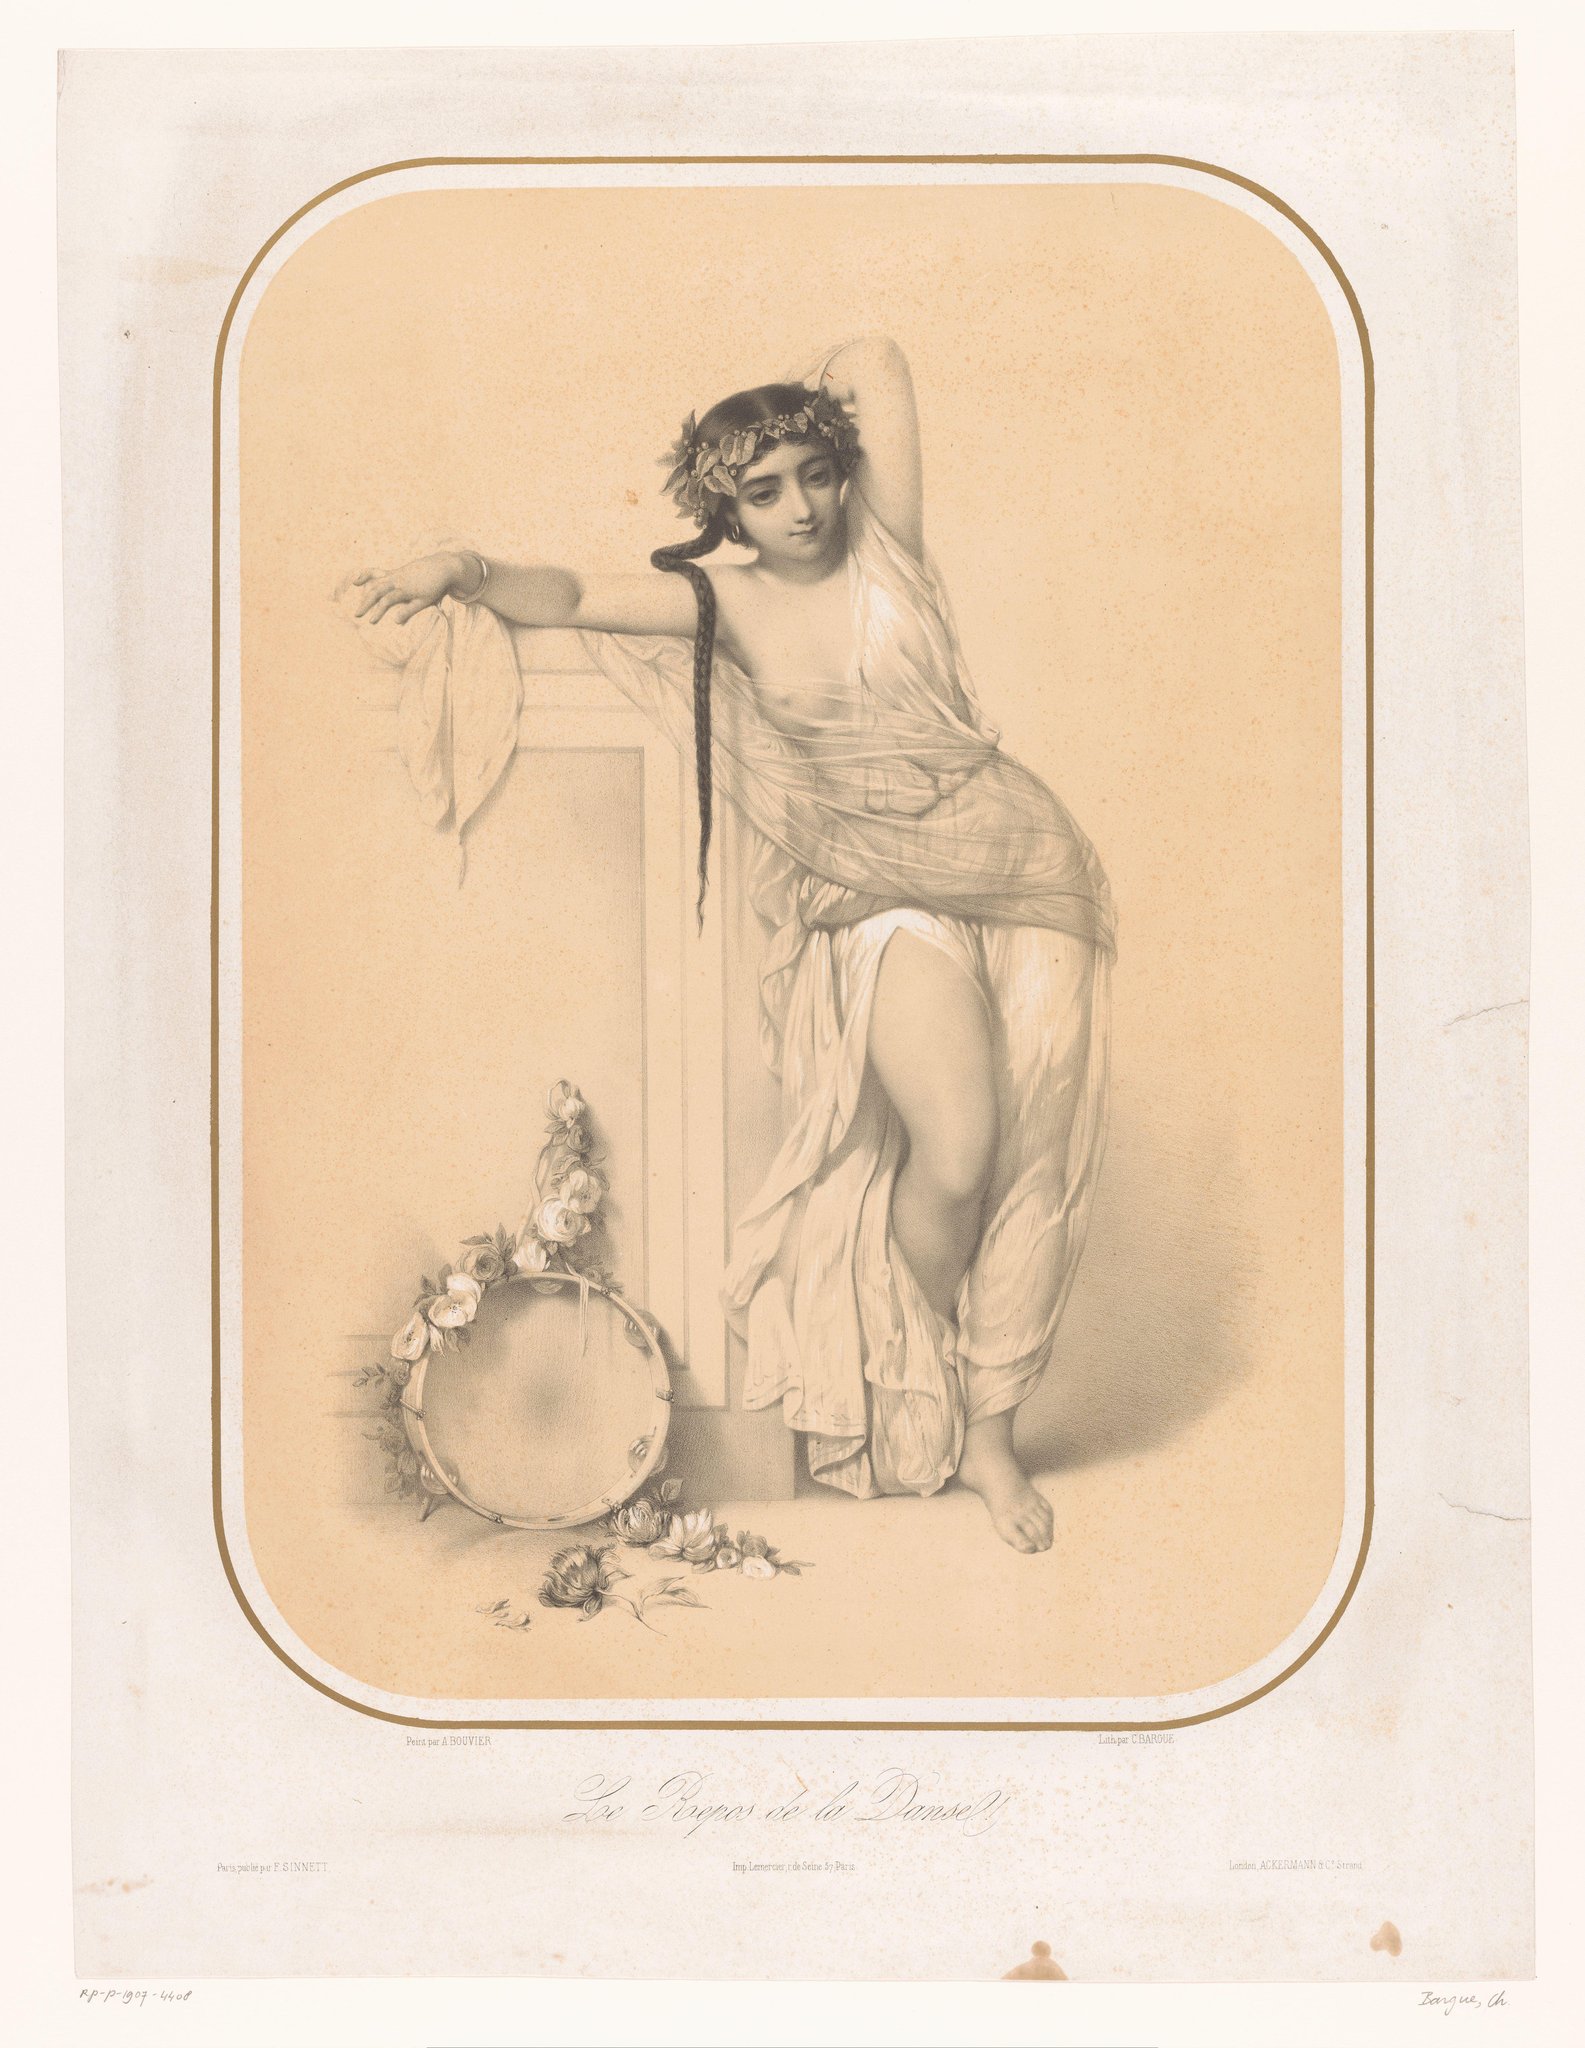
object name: print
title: Vier voorstellingen van de liefde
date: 1855-1856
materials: paper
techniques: tone lithography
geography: paris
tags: attributes of cupid: arrow(s), venus and cupid (cupid not being mere attribute)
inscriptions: collector's mark: Lugt 2228a, check stamp: Lugt 652g